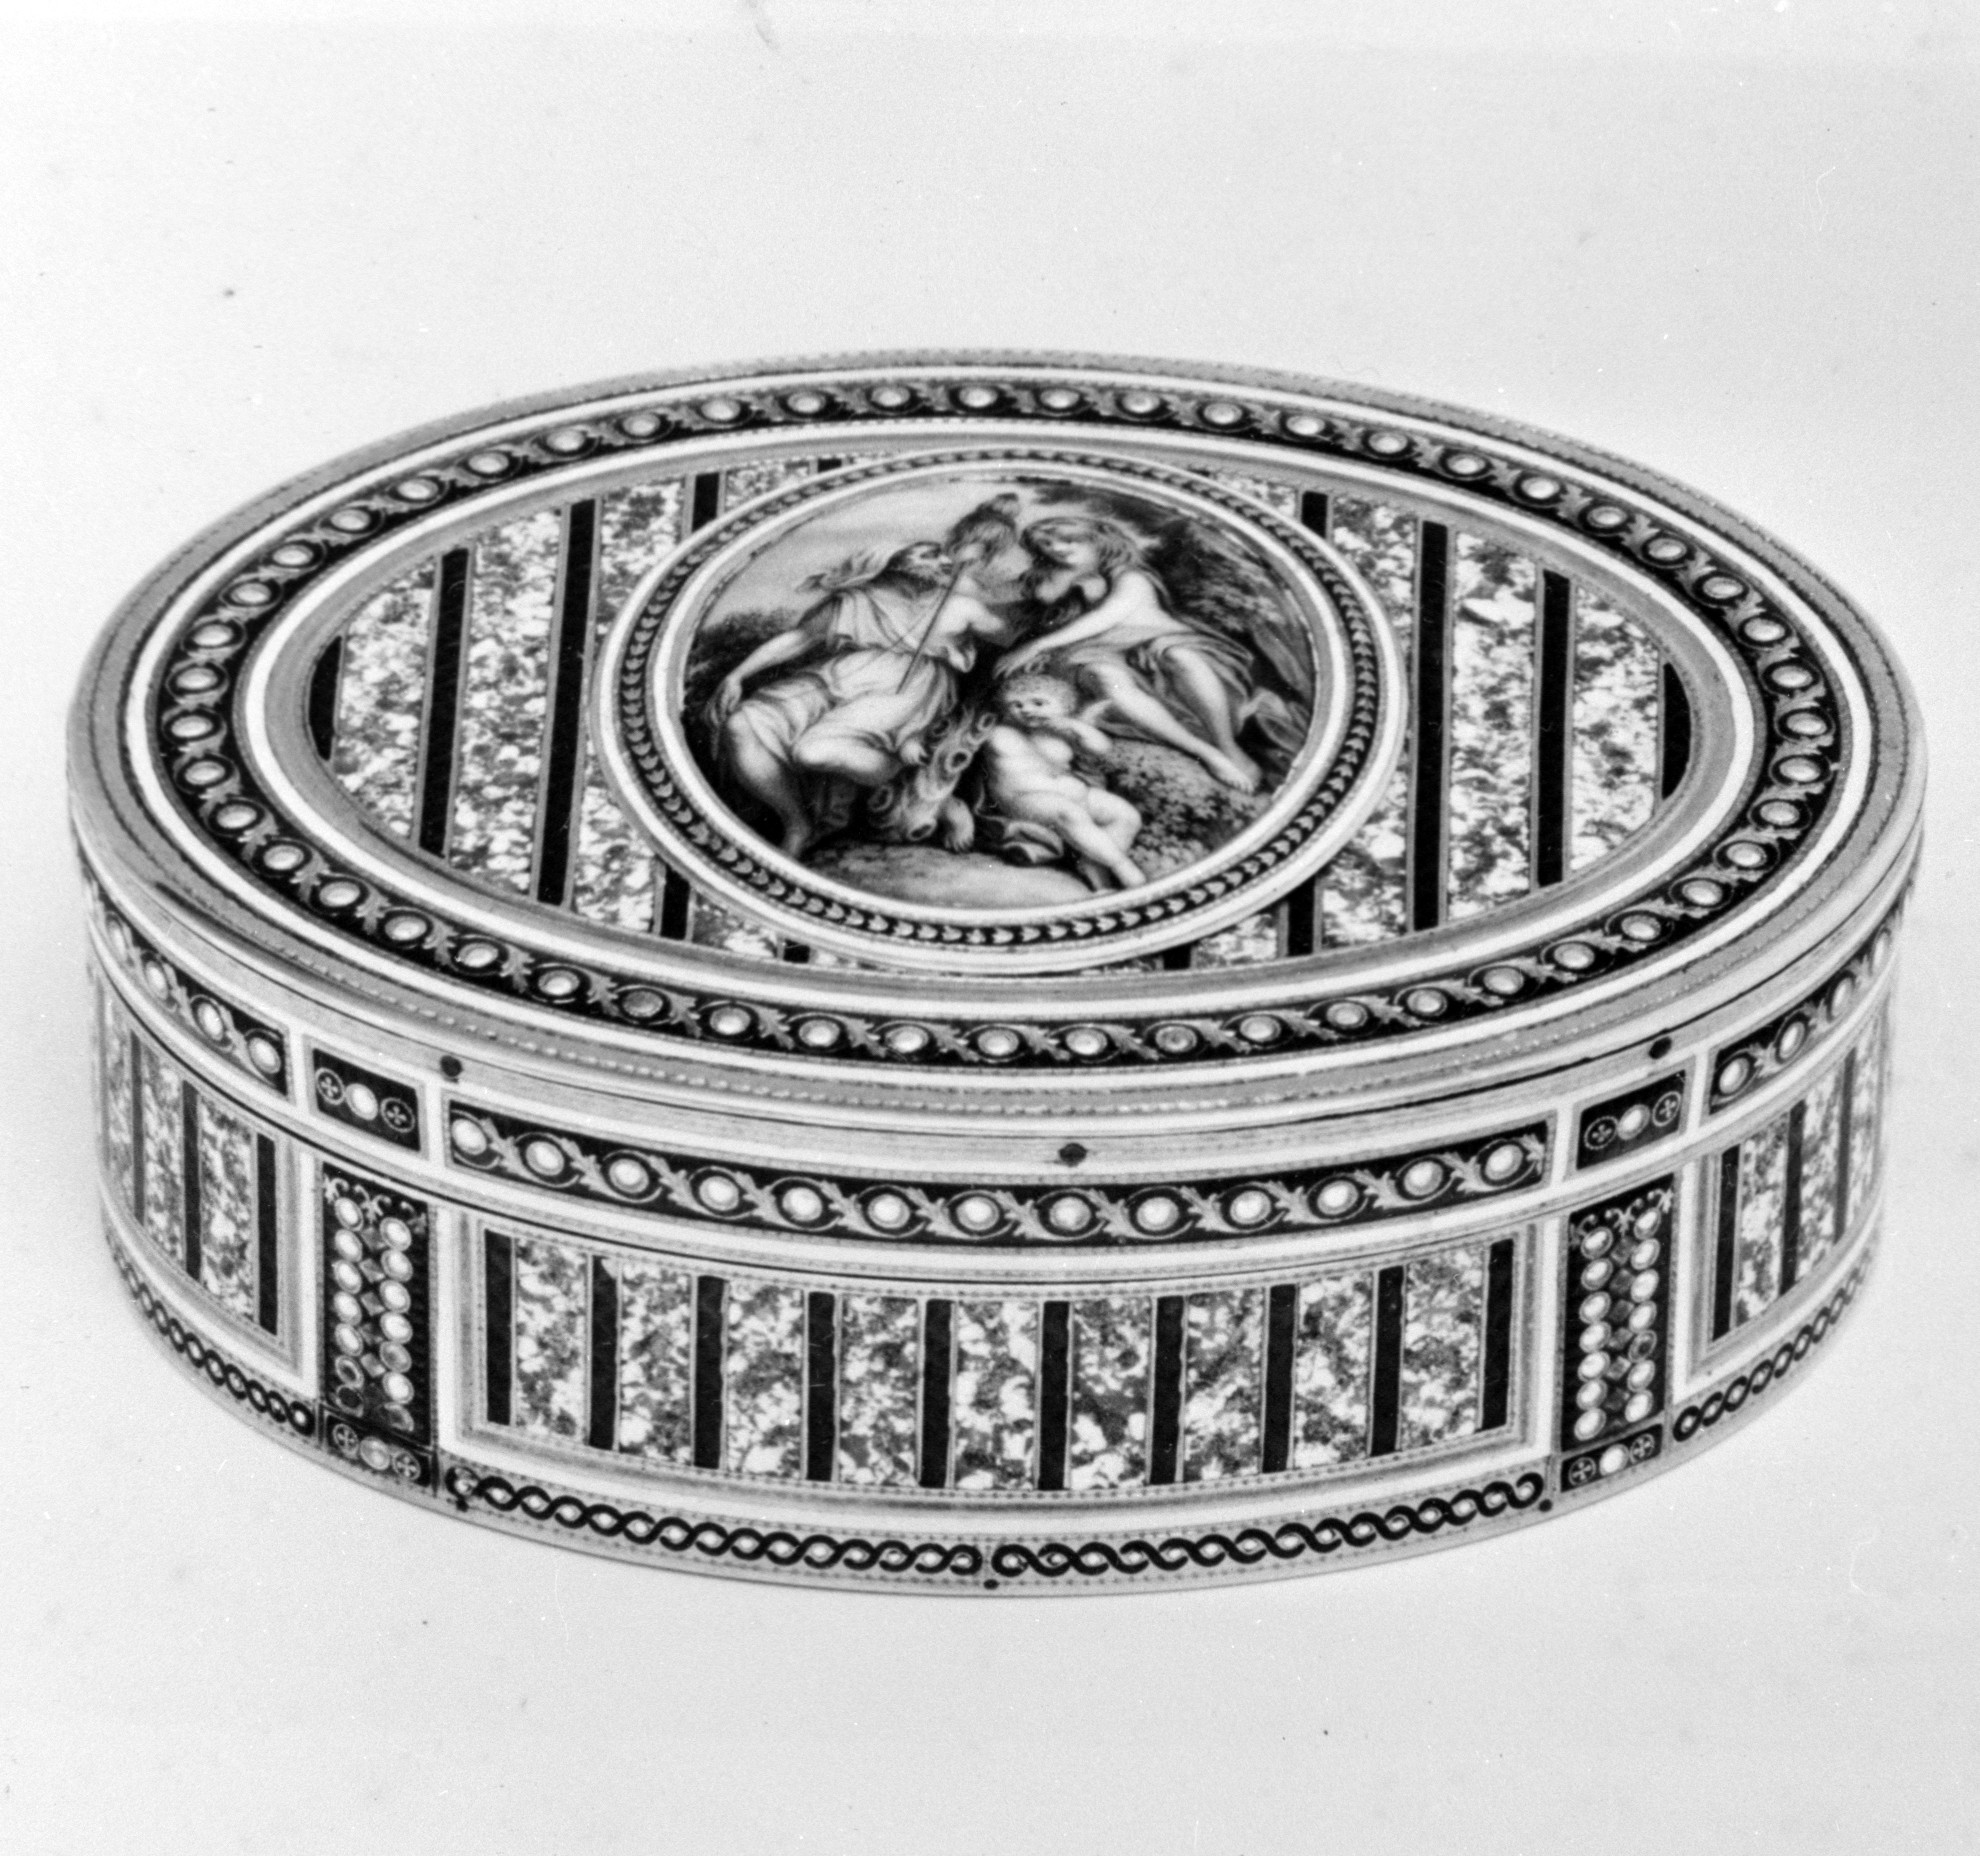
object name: snuffbox, painting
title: Snuffbox with miniature of Hercules, Omphale and Cupid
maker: joseph etienne blerzy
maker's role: maker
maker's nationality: french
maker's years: 1750-1806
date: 1789-1790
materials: enamel, gold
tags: cupid,hercules